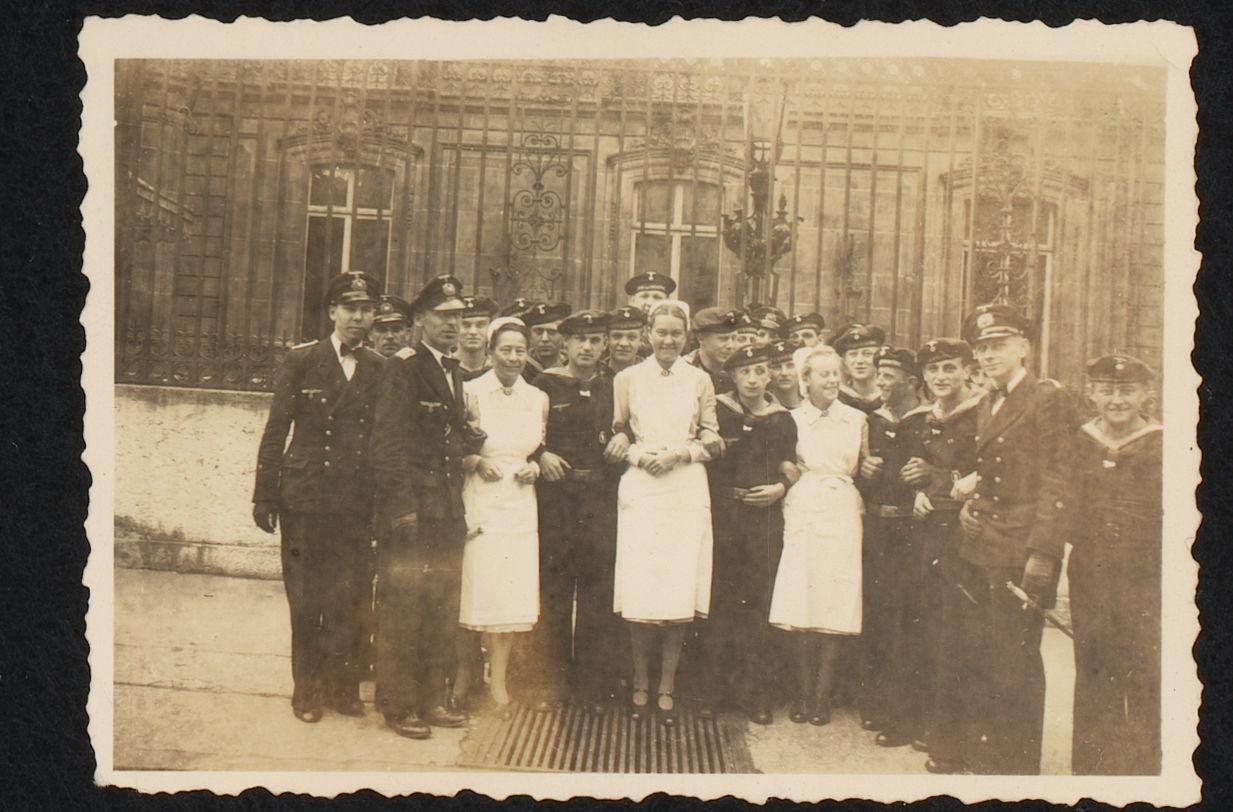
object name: photograph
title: Matrozen en drie verpleegsters in Parijs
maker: Anonymous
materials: photographic support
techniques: gelatin silver print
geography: paris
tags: the company, the unit, the troop ~ military service, nurse ~ hospital, sailor, paris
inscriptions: inscription: ‘Paris. 1.5 - 4.5.1943 // neben der Schwester rechts’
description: Groep Duitse matrozen in uniform en drie verpleegsters poseren voor een hek in Parijs, begin mei 1943. Vier van de mariniers zitten vooraan op hun hurken. Onderdeel van de groep losse foto's behorend bij het fotoalbum over de Kriegsmarine 1940-1943.